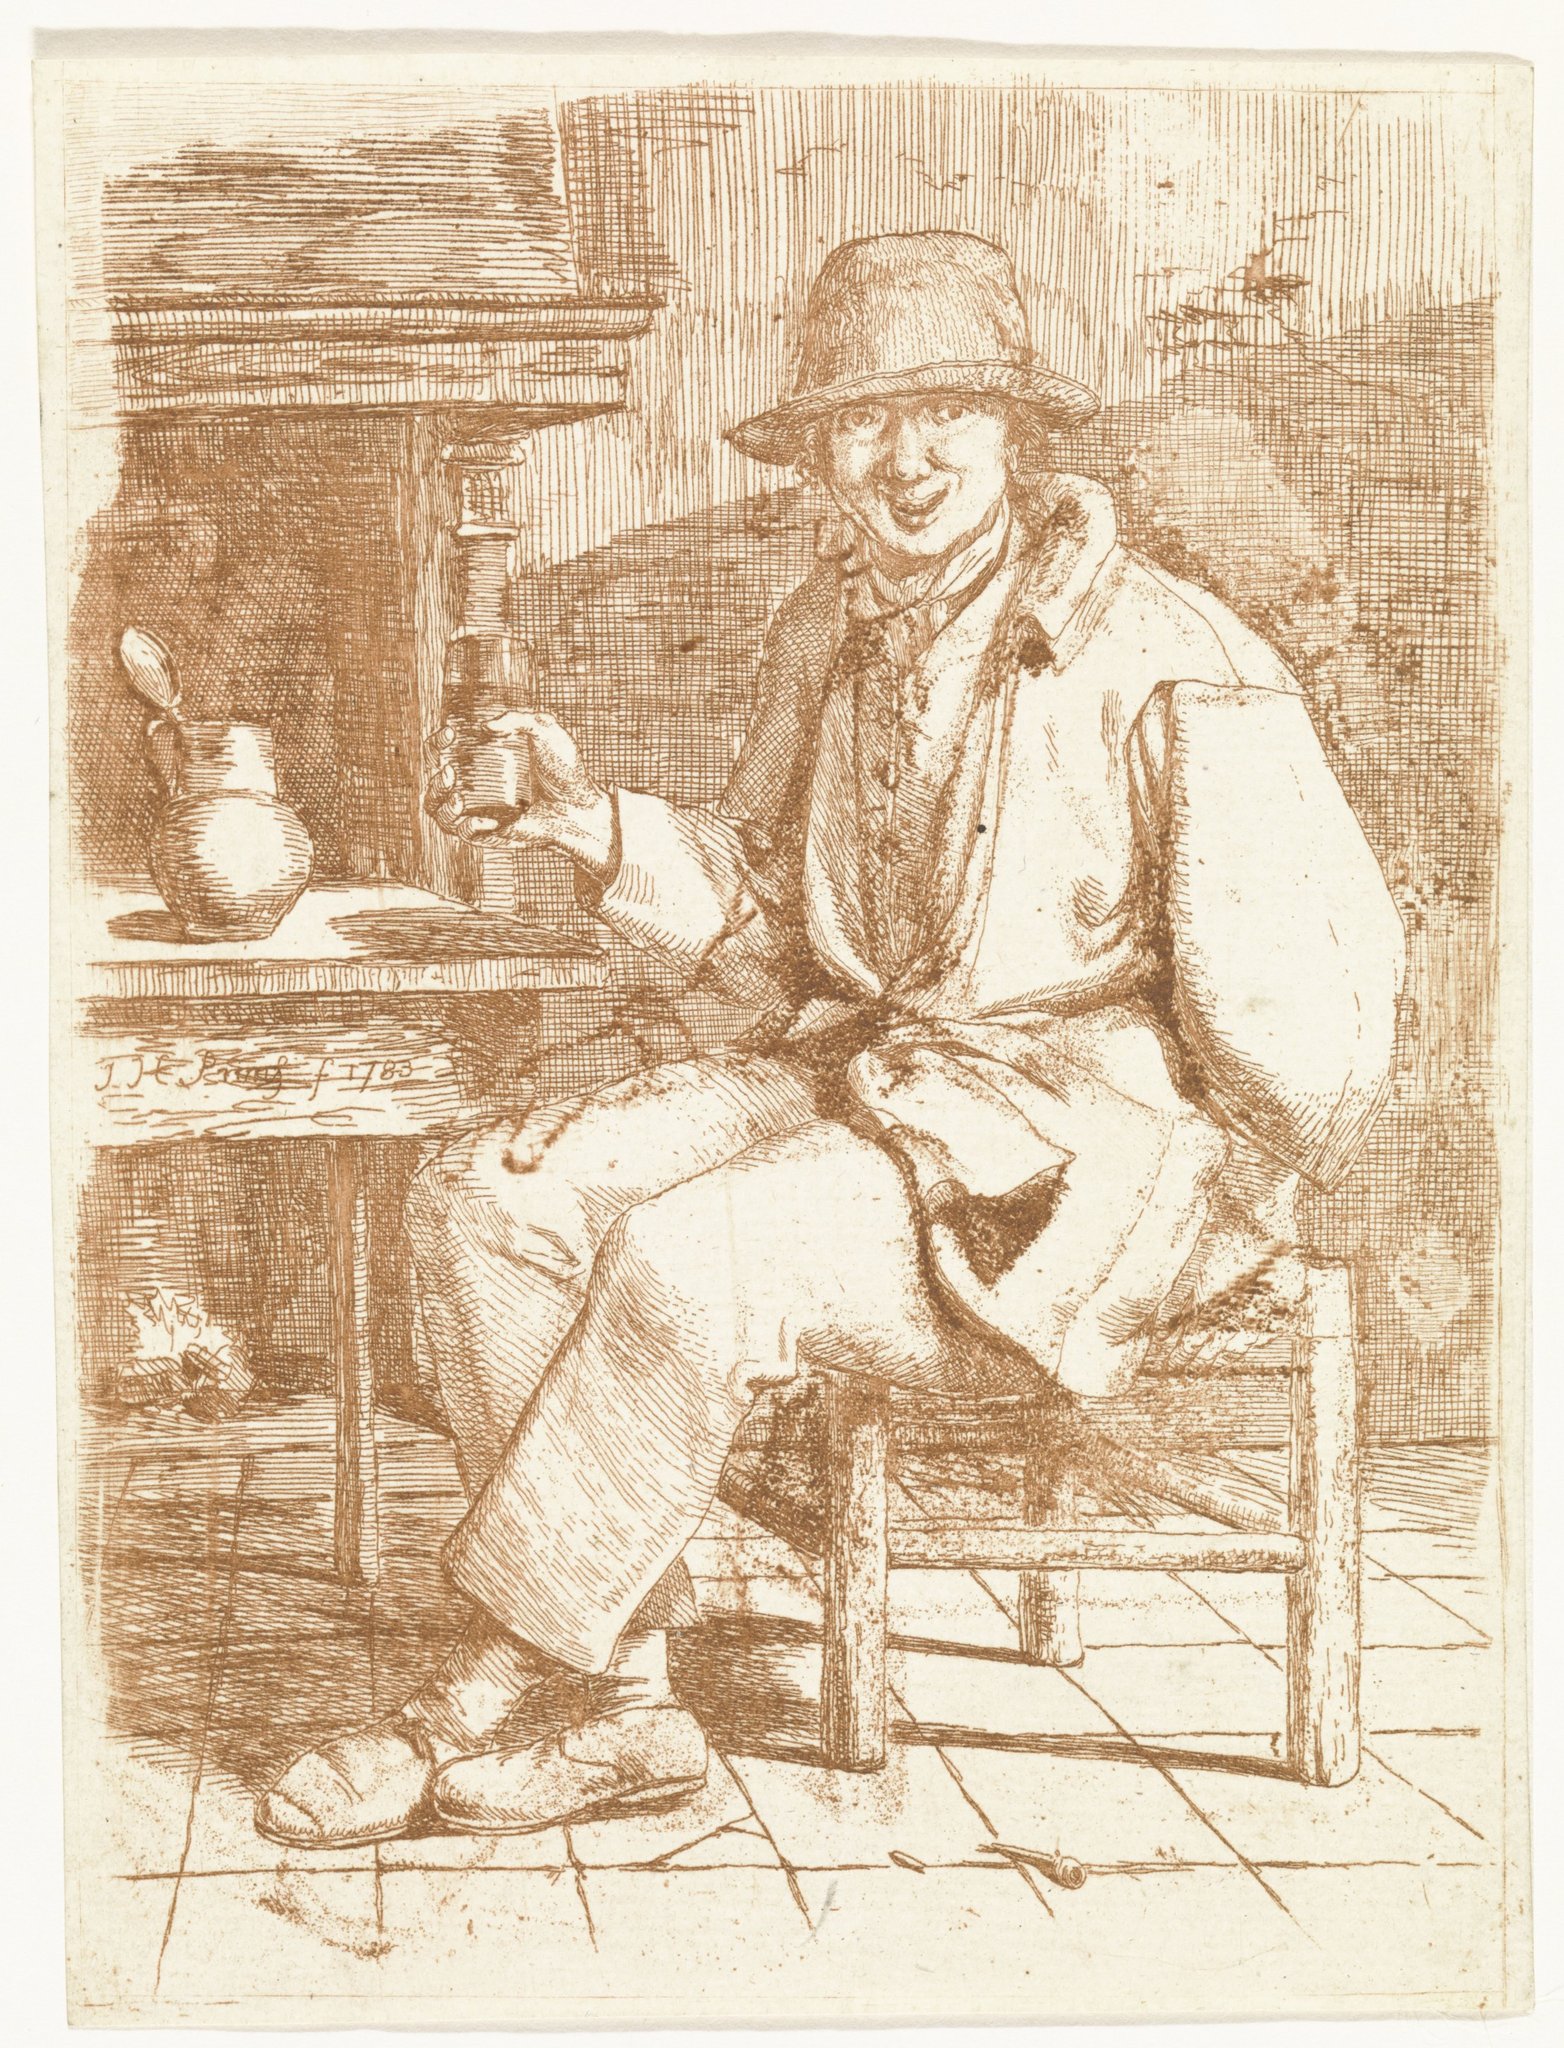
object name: print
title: Lachende man met glas in de hand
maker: johannes huibert prins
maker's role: draughtsman, painter, print maker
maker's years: 1757-1806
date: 1783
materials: paper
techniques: printmaking, etching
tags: sitting figure, head-gear: cap (+ men's clothes)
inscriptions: collector's mark: Lugt 2228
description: Een lachende man met hoed op en jas aan zit op een kruk bij een tafel. In zijn hand heeft hij een glas vast. Op tafel staat een tinnen kruik. Op de achtergrond een haard met brandend turfvuur. Er zijn restanten te zien van de oorspronkelijke compositie, waarin de man zijn rechterhand op zijn knie laat rusten. In tegenstelling tot de eerdere staten is de man nu en face afgebeeld.